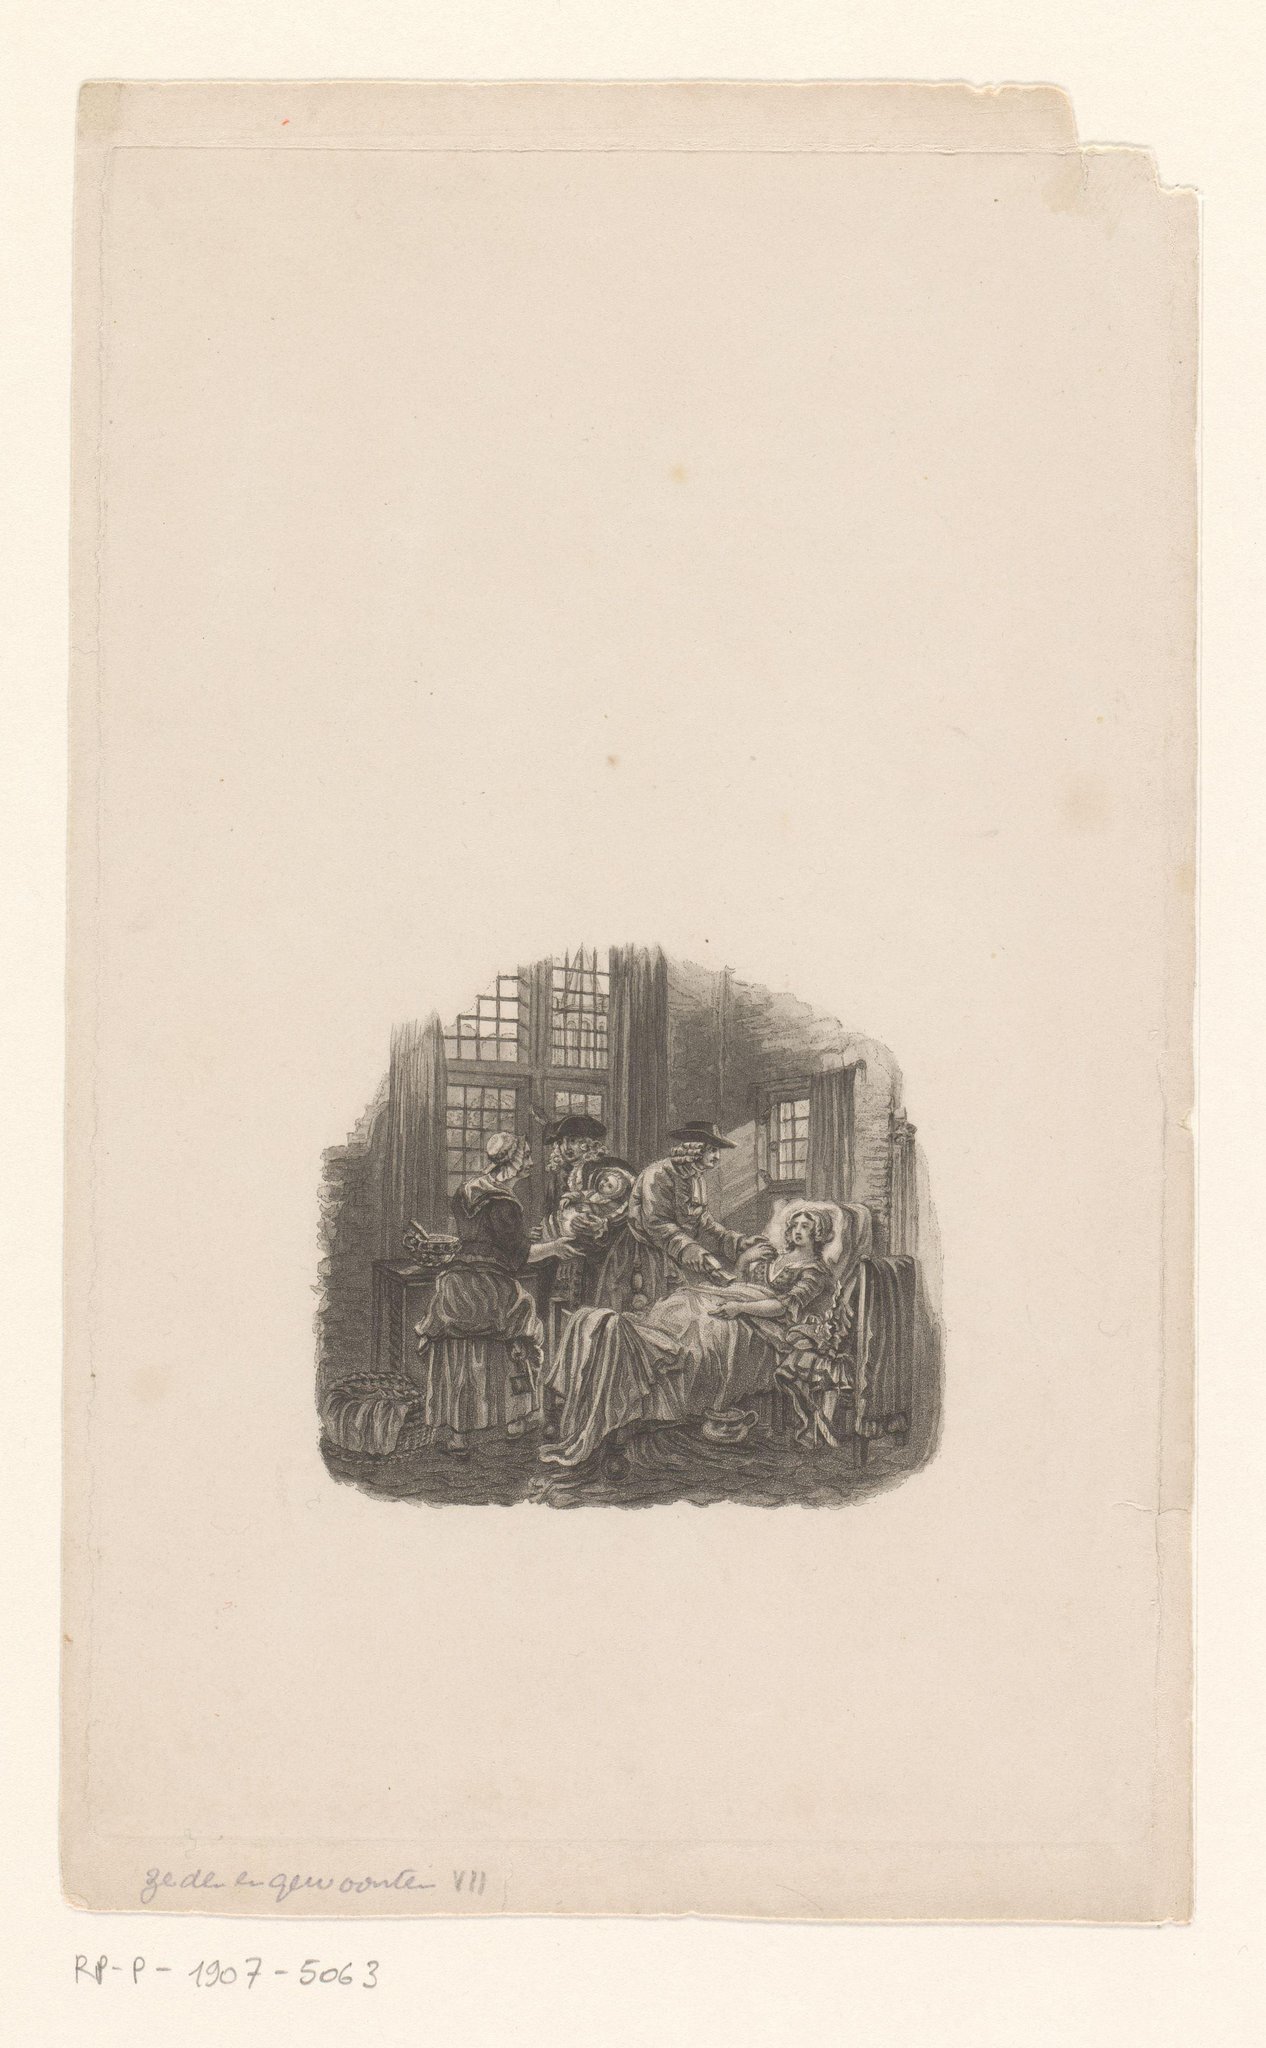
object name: print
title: Interieur met vrouw in kraambed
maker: Anonymous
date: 1790-1840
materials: paper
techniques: aquatint, etching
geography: northern netherlands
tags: first care of new-born baby, visiting the new mother, lying-in visit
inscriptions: collector's mark: Lugt 2228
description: Waarschijnlijk een proefdruk voor een boekillustratie of titelpagina.